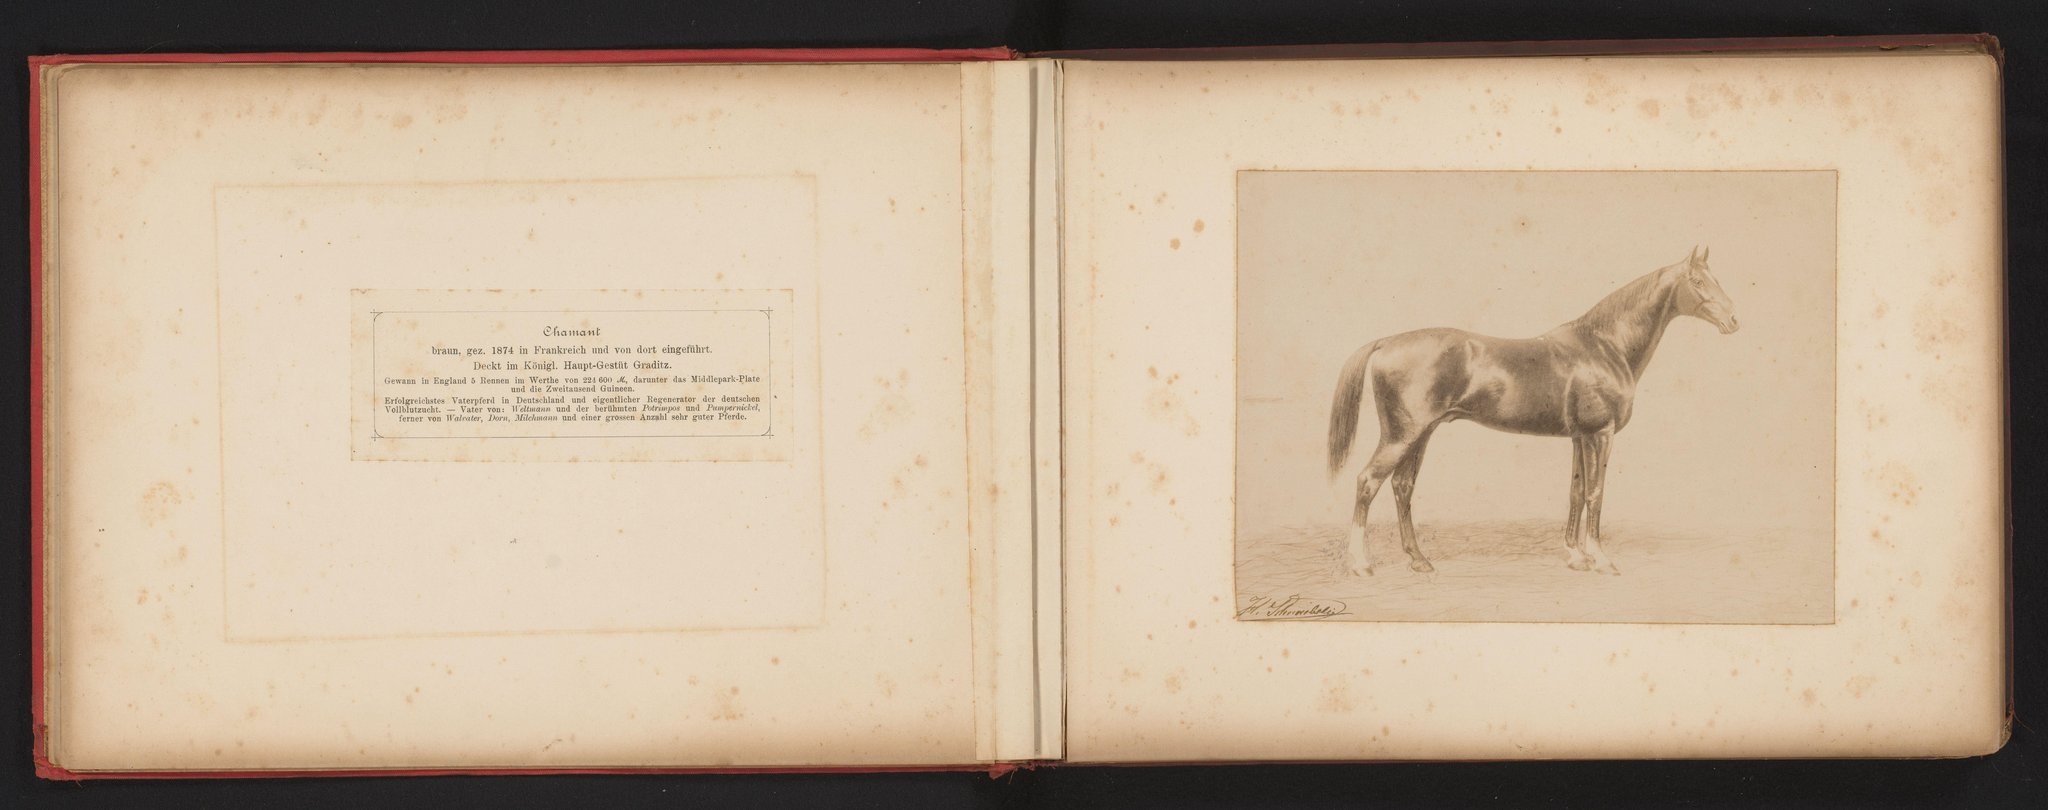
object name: photograph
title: Fotoreproductie van een tekening van een paard, genaamd Charmant, door H. Schnaebeli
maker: h. schnaebeli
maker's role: fotograaf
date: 1894-1915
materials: photographic support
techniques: albumen print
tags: horse